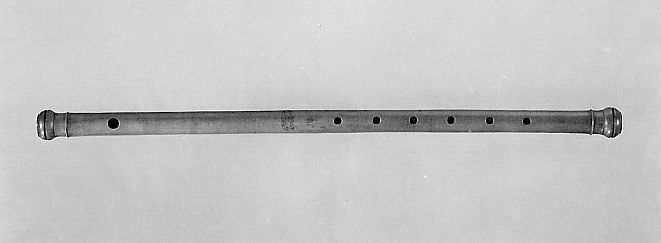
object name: schwegel in b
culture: german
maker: g. walch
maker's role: maker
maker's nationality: german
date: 1750-1770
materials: wood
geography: germany